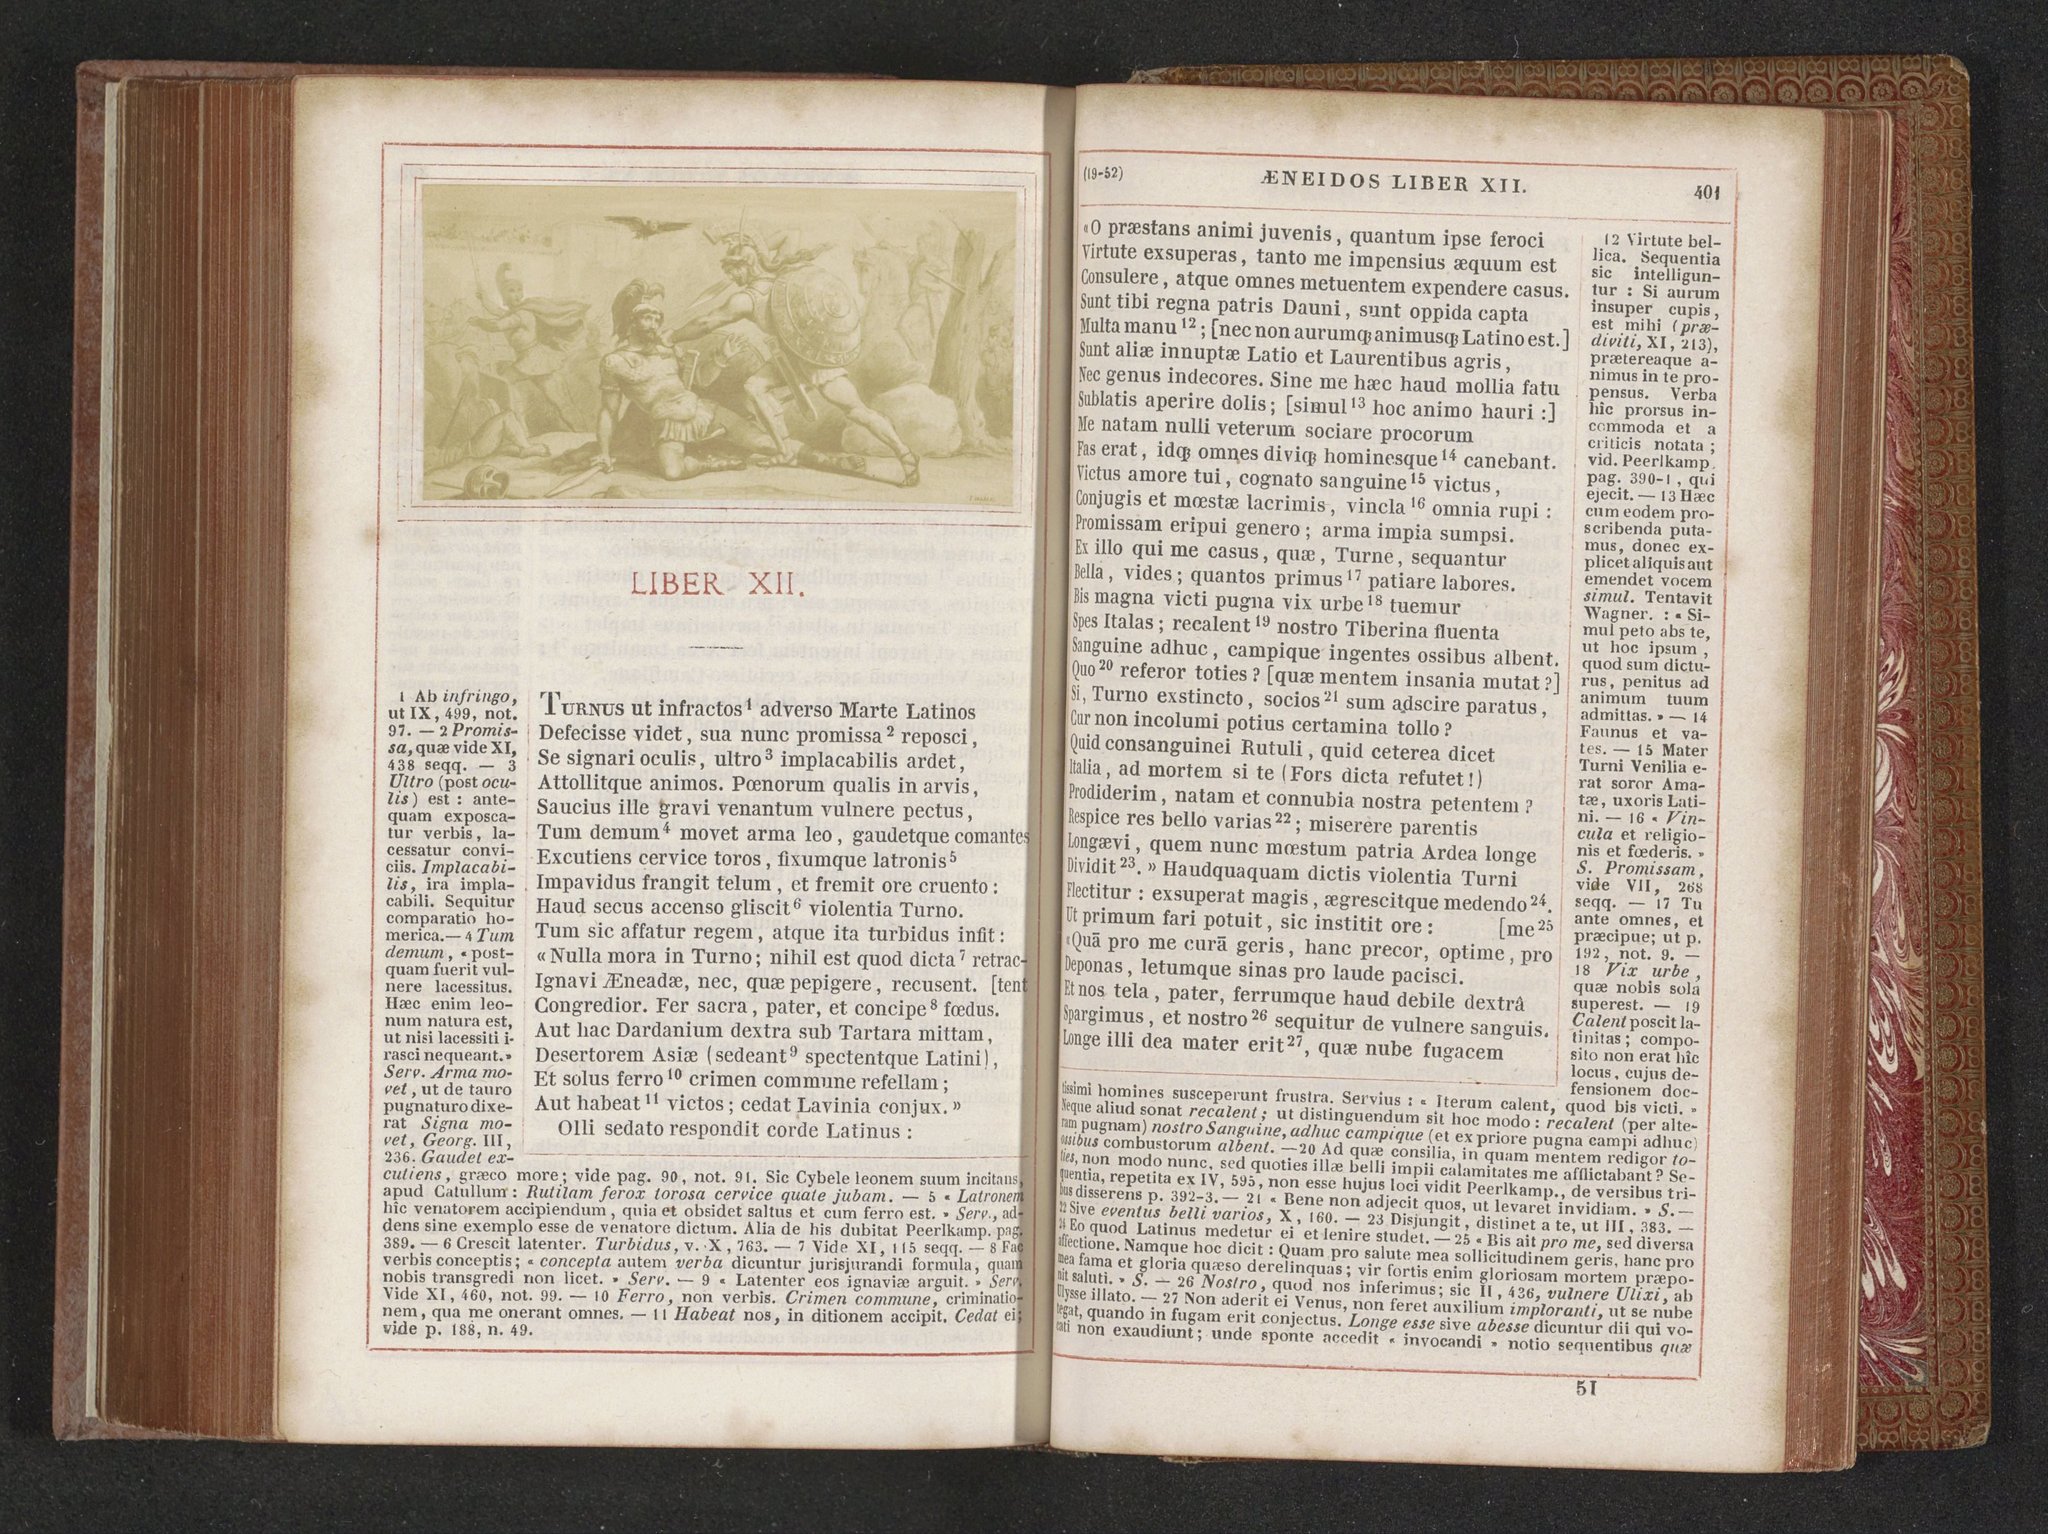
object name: photograph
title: Fotoreproductie van een schilderij, voorstellende de tweestrijd van Turnus en Aeneas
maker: Anonymous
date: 1850-1858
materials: photographic support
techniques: albumen print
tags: turnus is killed by aeneas, jupiter sends one of the furies in the form of a dark bird which flies into turnus' face and beats against his shield